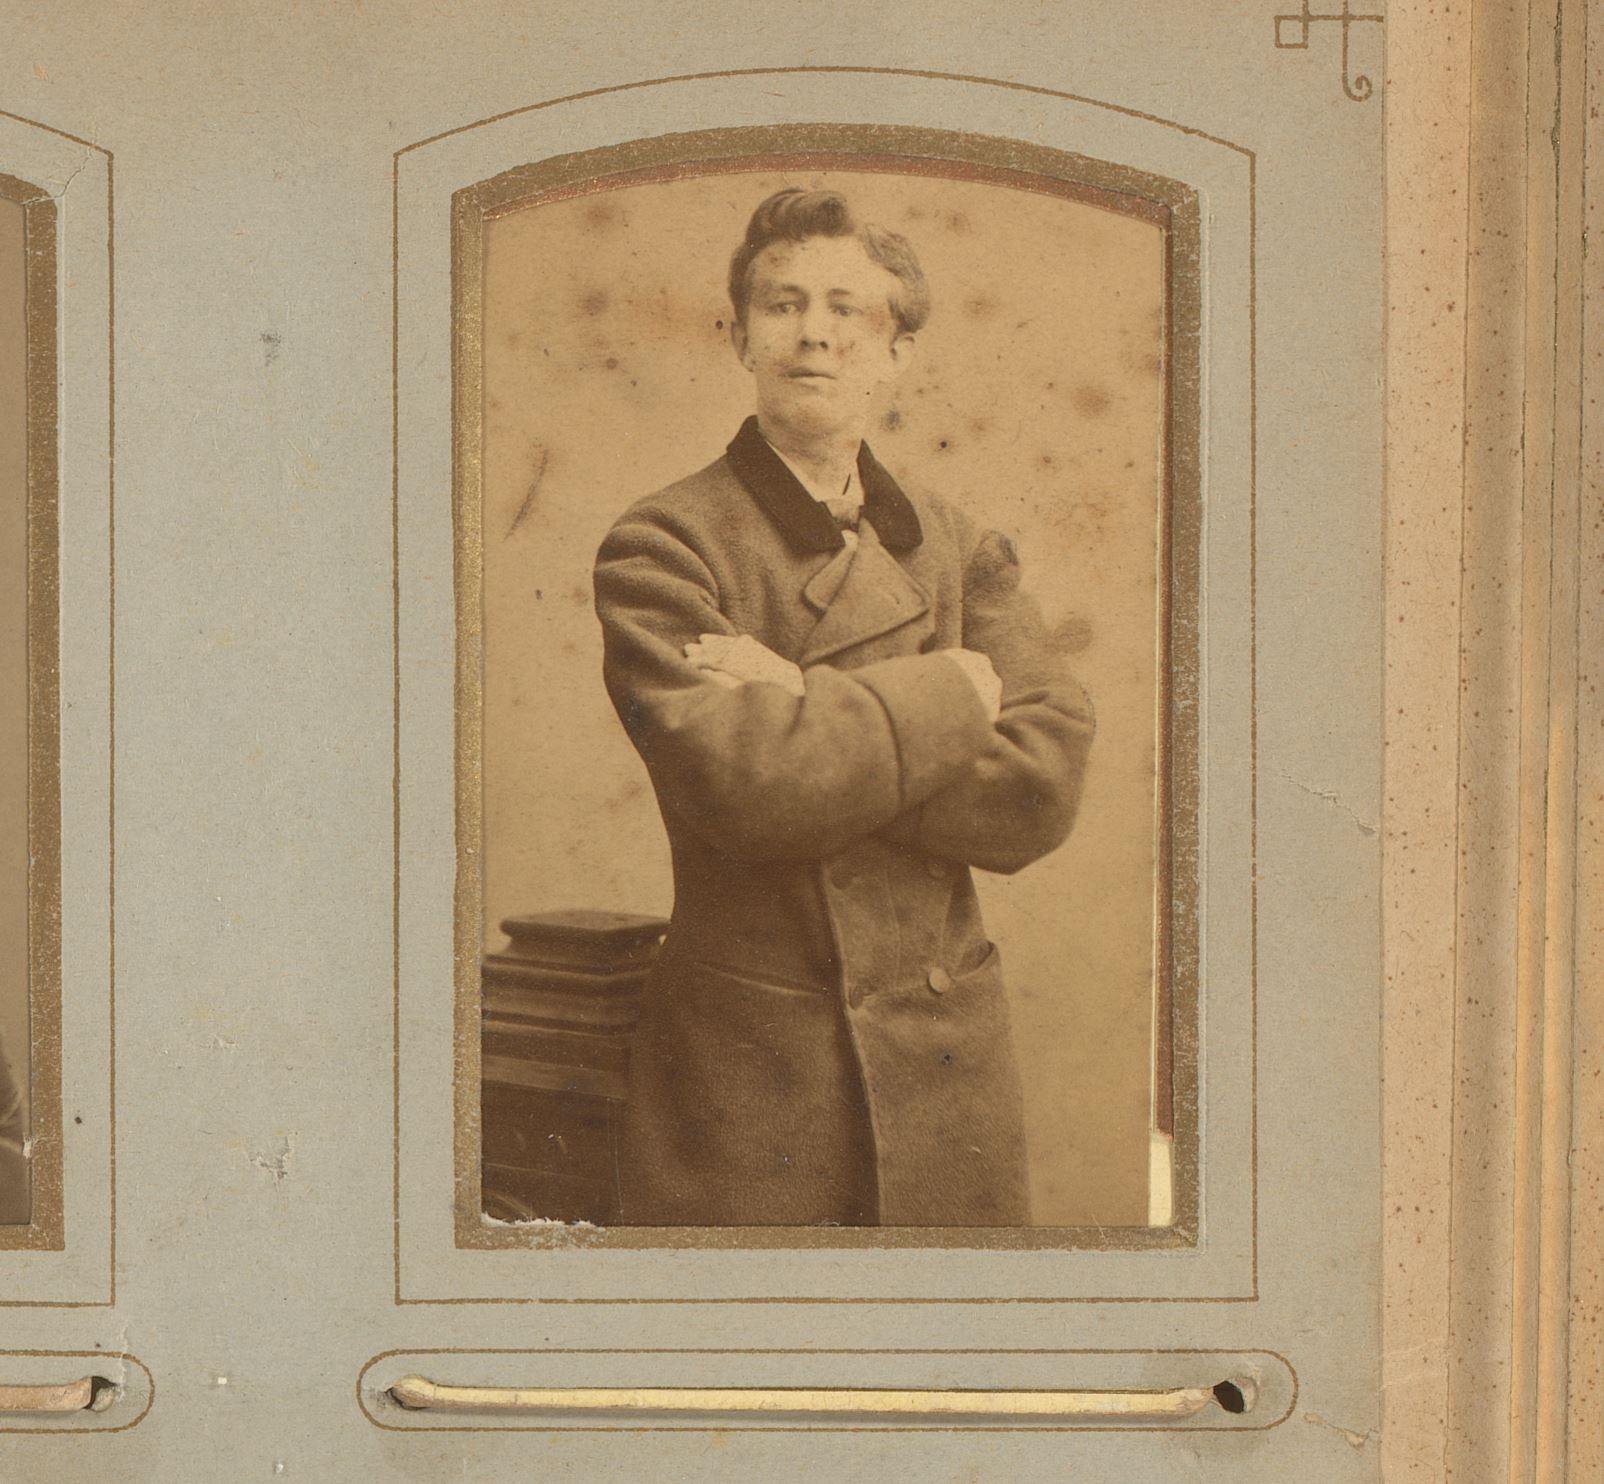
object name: photograph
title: Portret van een staande man met de armen over elkaar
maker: heinrich wilhelm wollrabe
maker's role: fotograaf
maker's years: 1843-1928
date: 1870-1910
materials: cardboard, photographic support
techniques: albumen print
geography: the hague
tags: standing figure, historical persons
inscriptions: inscription: ‘(...)/ H.W. Wollrabe/ Hofphotograaf van Z.M. den Koning en van H.M. de Koningin der Nederlanden./ 96. Noordeinde 96./ 'S GRAVENHAGE./ Voor nabestelling wordt de origineele plaat bewaard.’